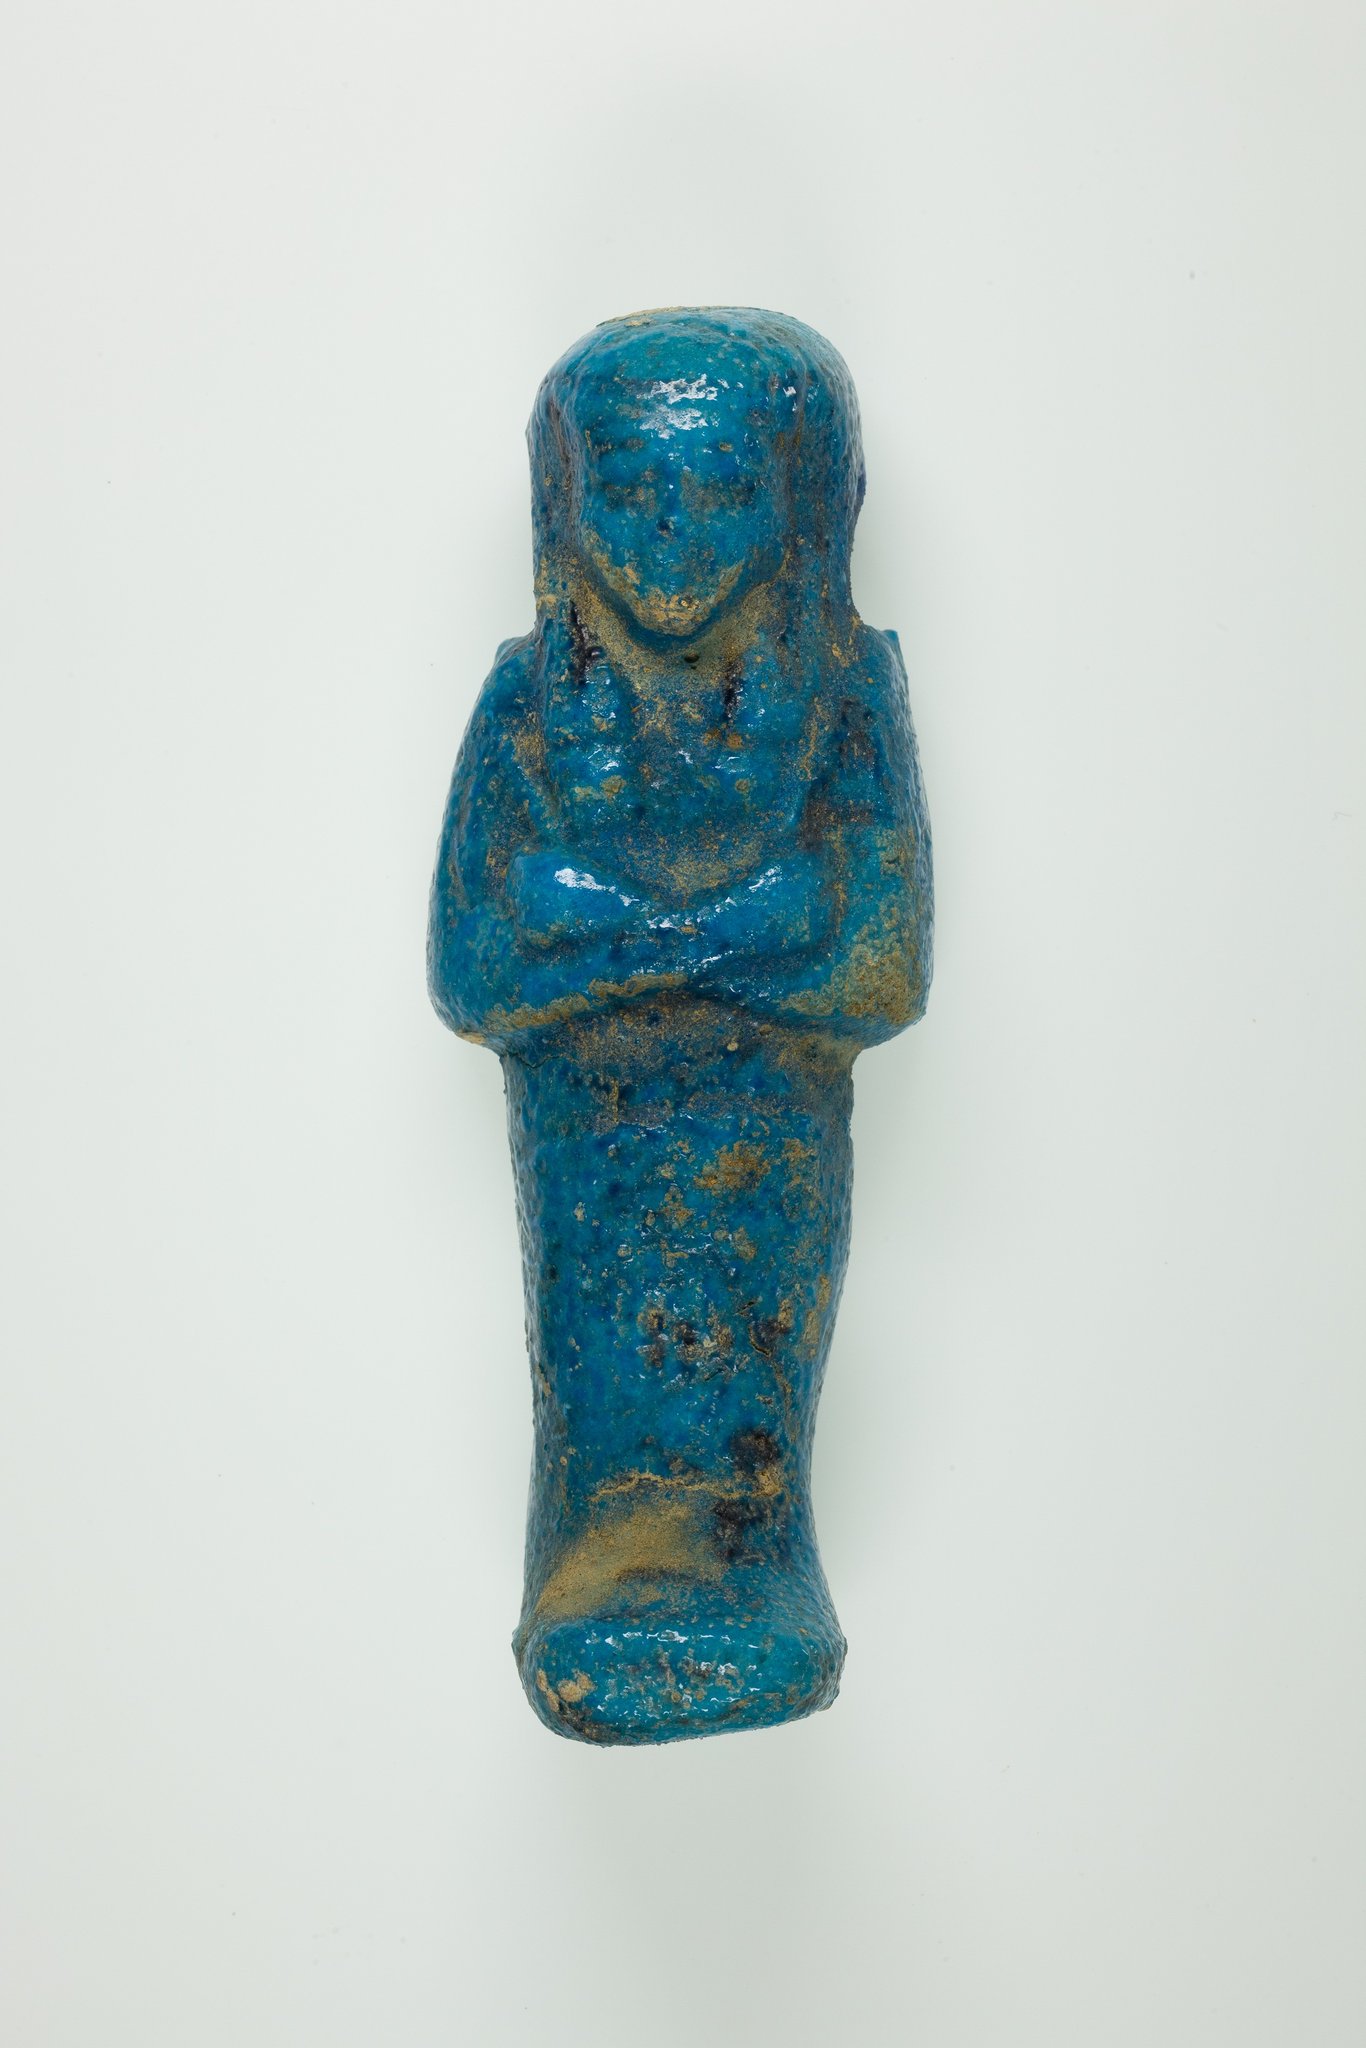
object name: worker shabti, henettawy c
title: Worker Shabti of Henettawy (C), Daughter of Isetemkheb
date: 990-970 BCE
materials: faience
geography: egypt